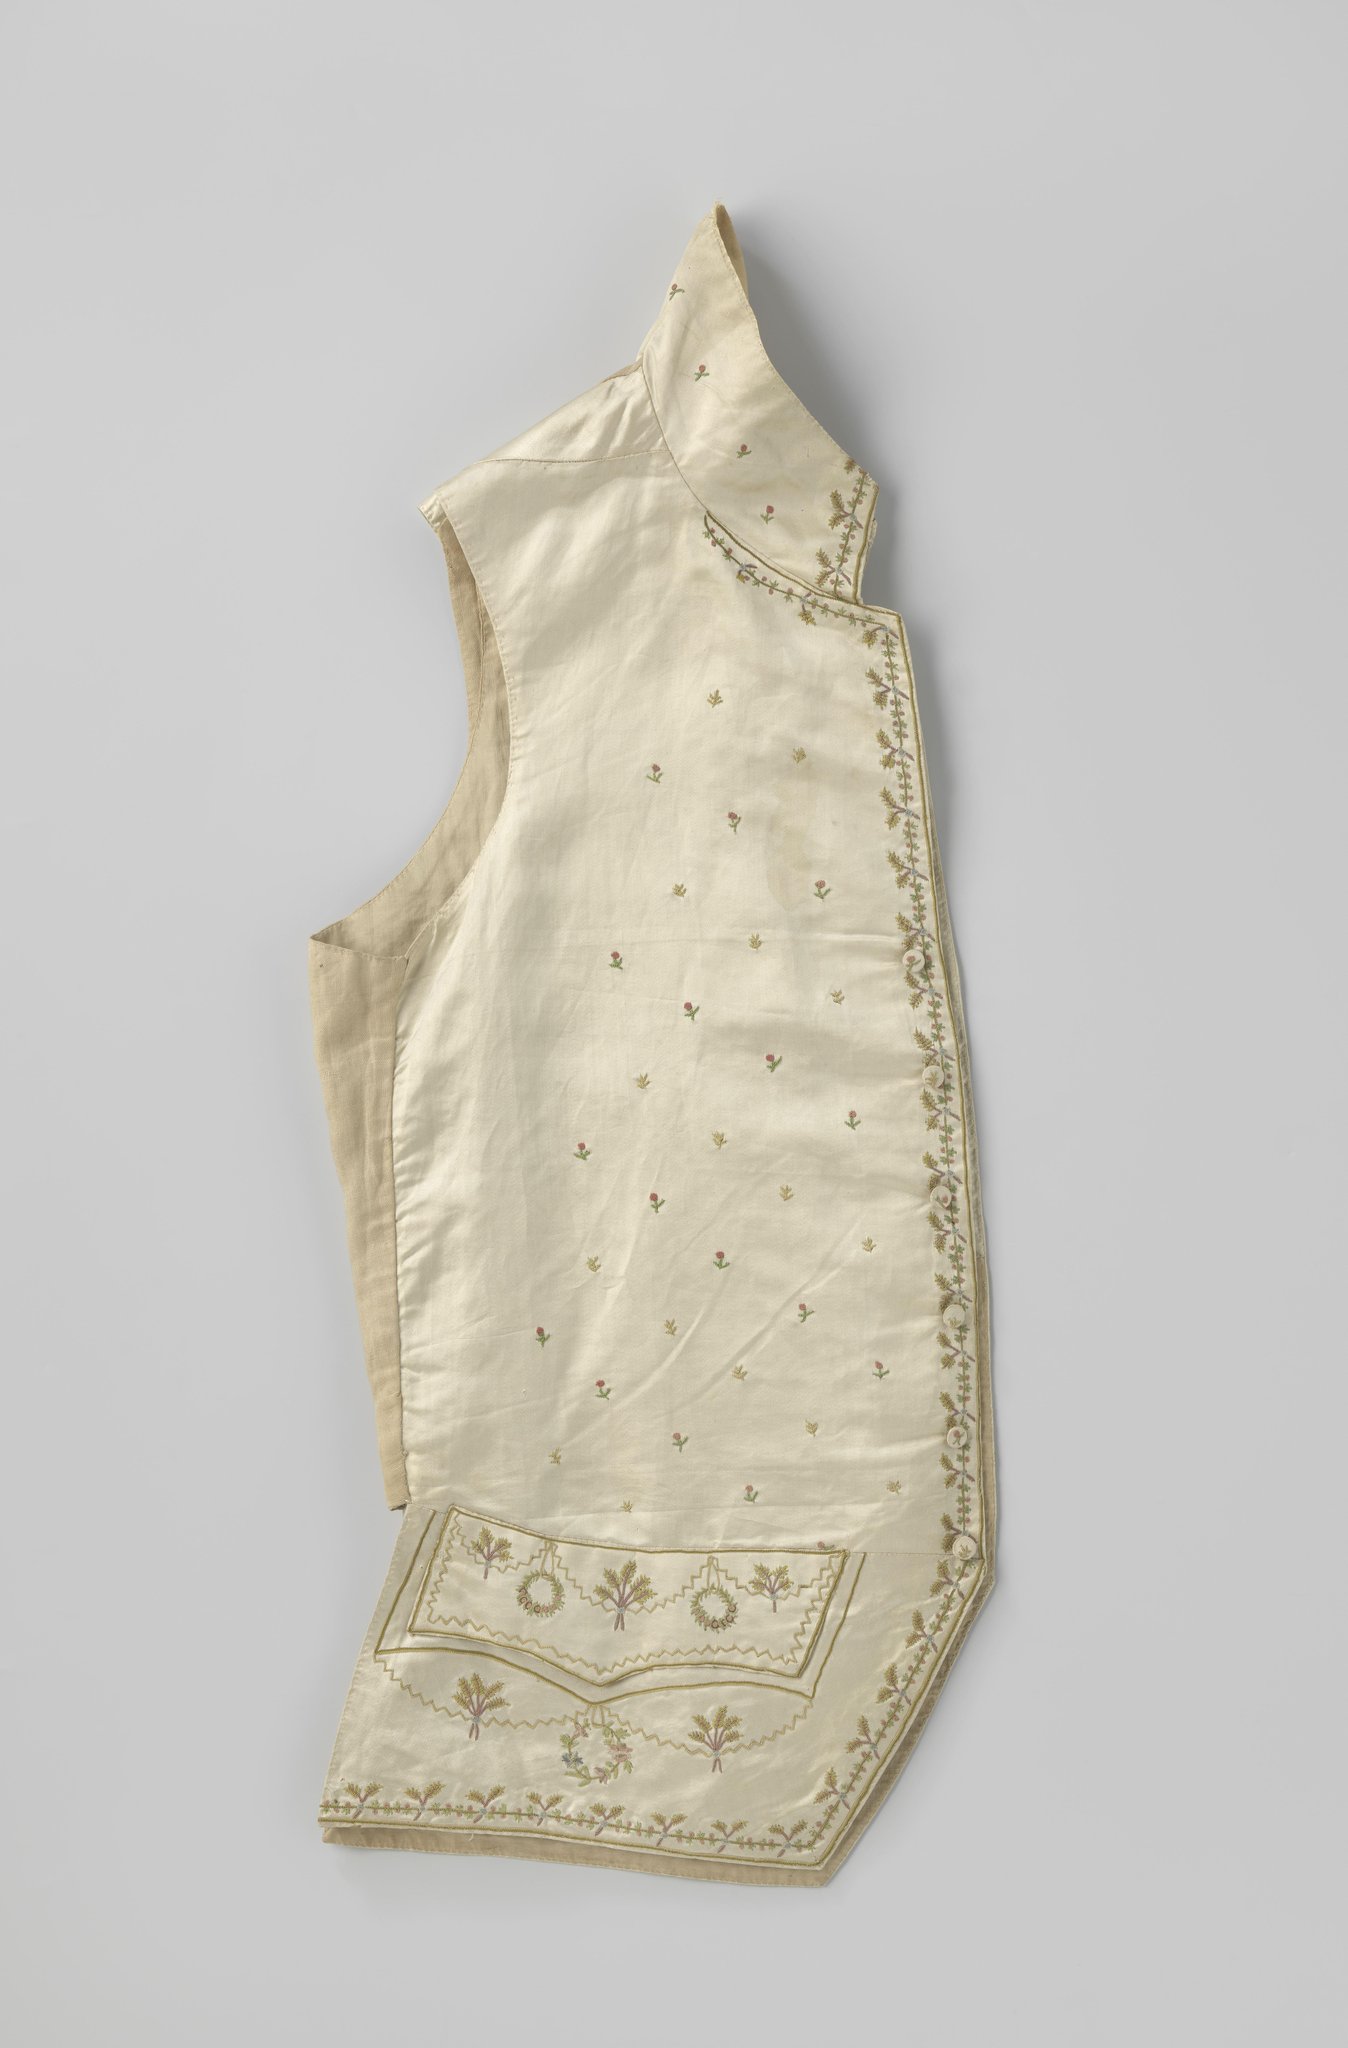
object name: menswear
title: Vest van wit satijn met smalle zijden bont geborduurde rand, kleine bloepjes, in tamboereerwerk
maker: Anonymous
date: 1785-1800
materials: textile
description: Vest van wit satijn met smalle zijden bont geborduurde rand, kleine bloepjes, in tamboereerwerk.